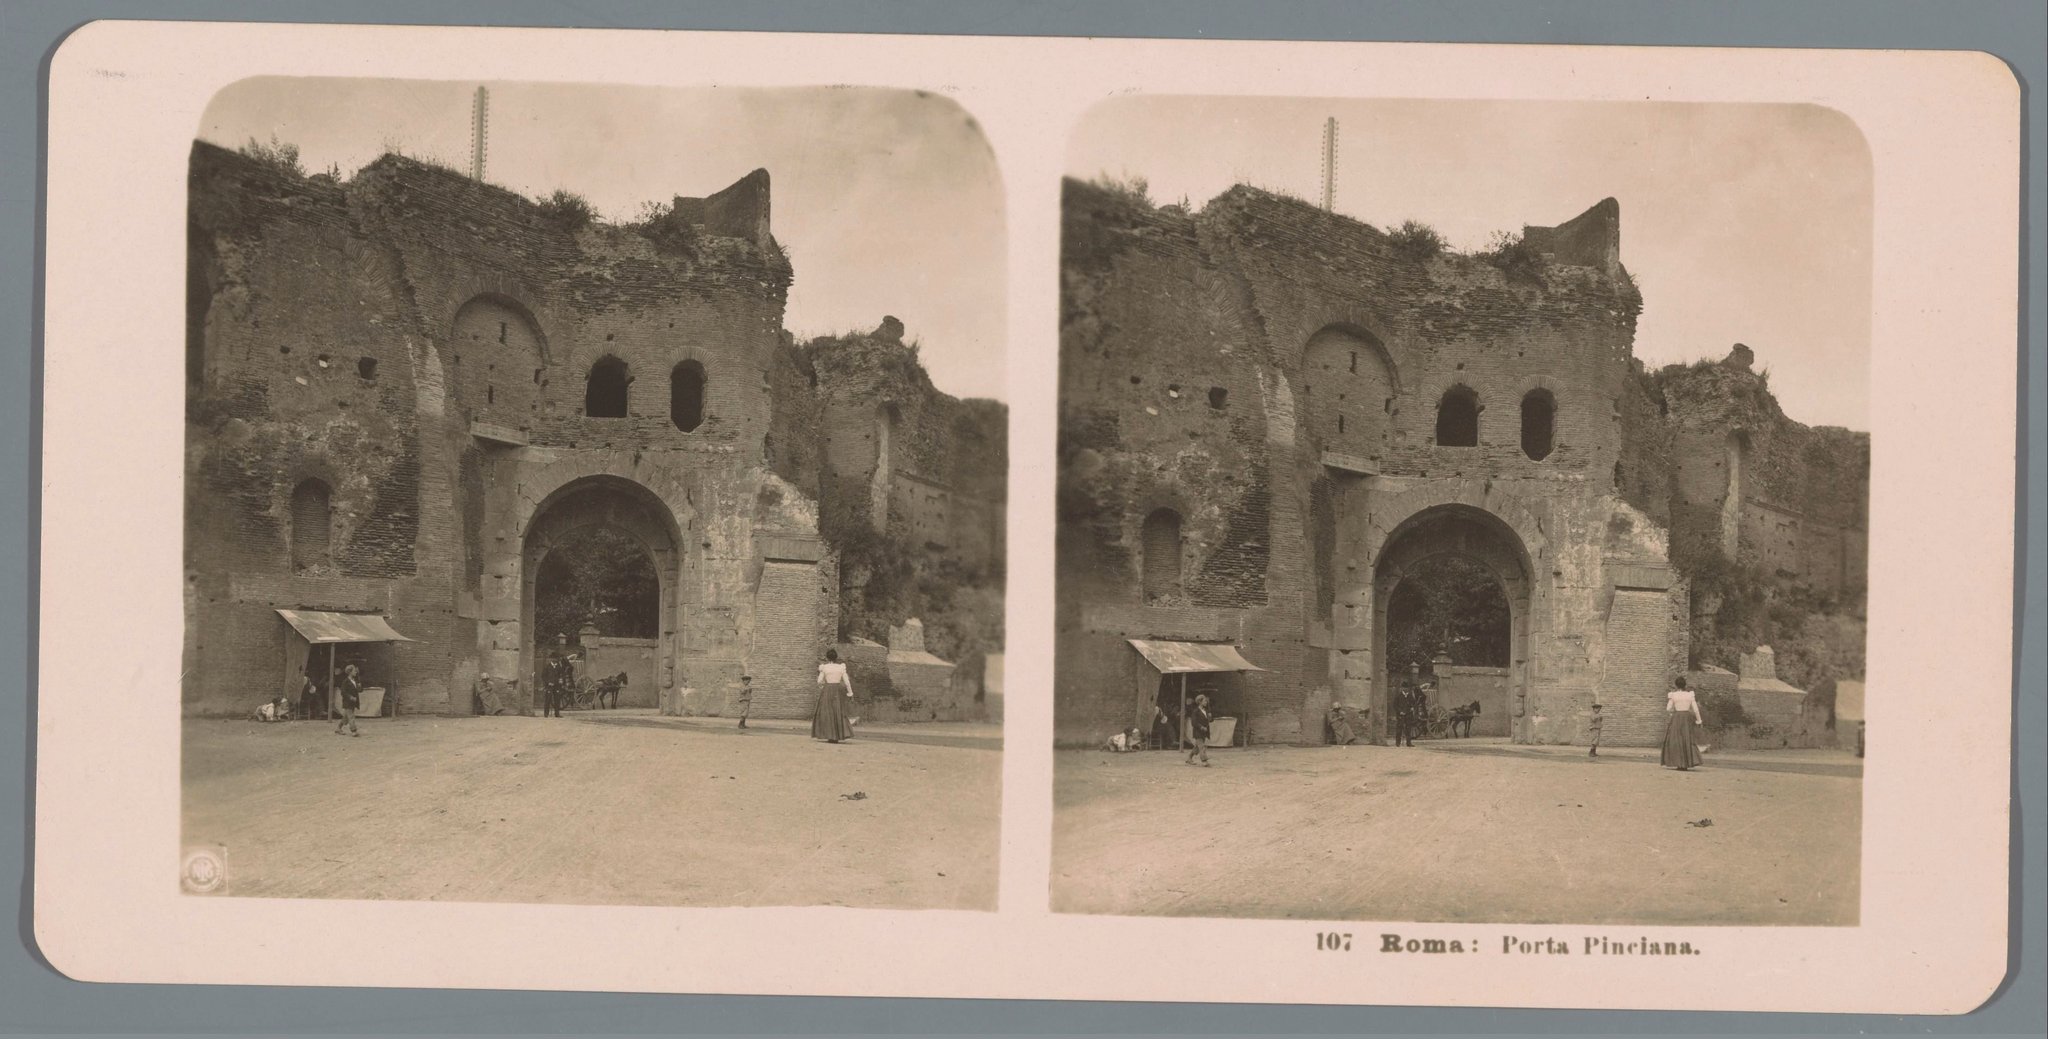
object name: stereograph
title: Porta Pinciana te Rome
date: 1900-1910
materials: cardboard, photographic support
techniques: gelatin silver print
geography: rome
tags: ruin of a building ~ architecture, gate, entrance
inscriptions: inscription: ‘NPG’, number: ‘107’